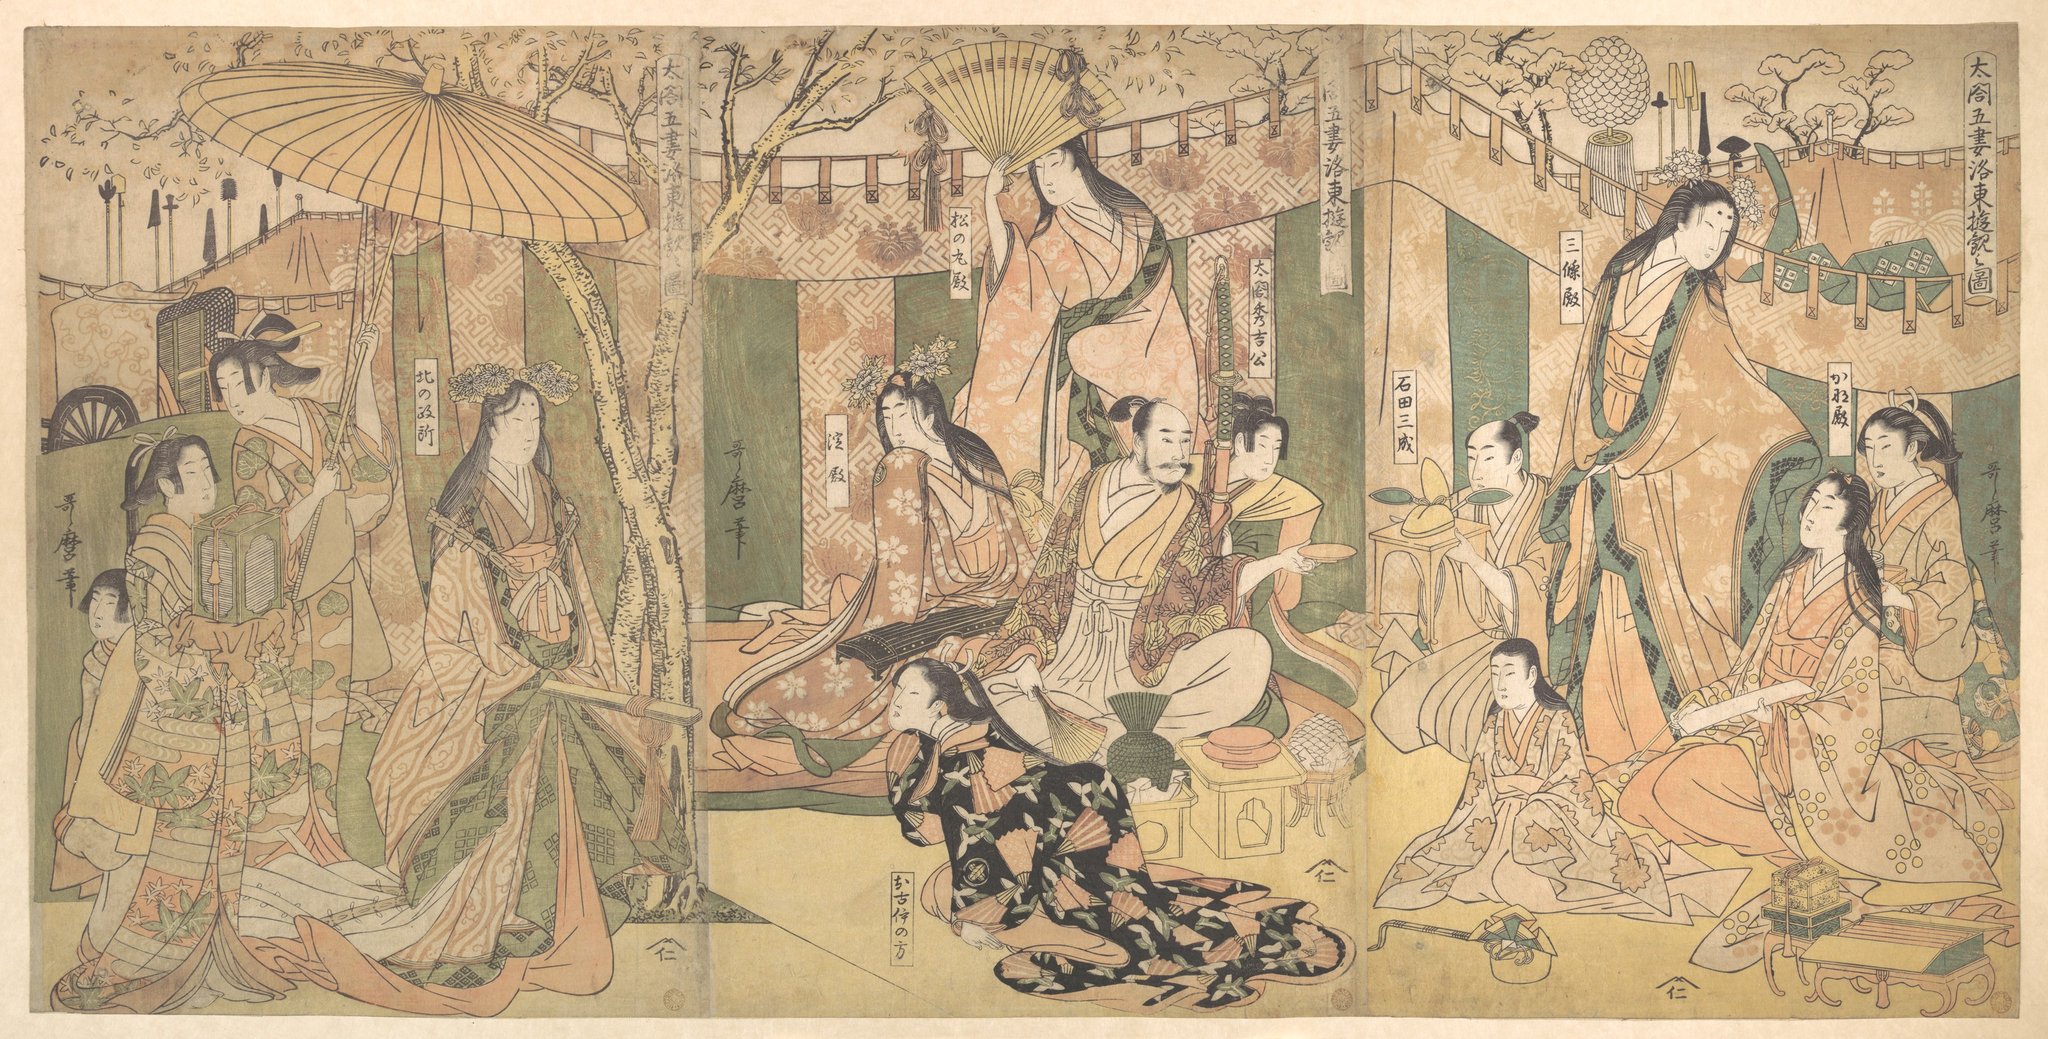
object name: print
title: A View of the Pleasures of the Taiko and His Five Wives at Rakutō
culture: japanese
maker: kitagawa utamaro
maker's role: artist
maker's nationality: japanese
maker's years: 1754-1806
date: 1804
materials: ink, paper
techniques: woodblock print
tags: fans,men,women,trees